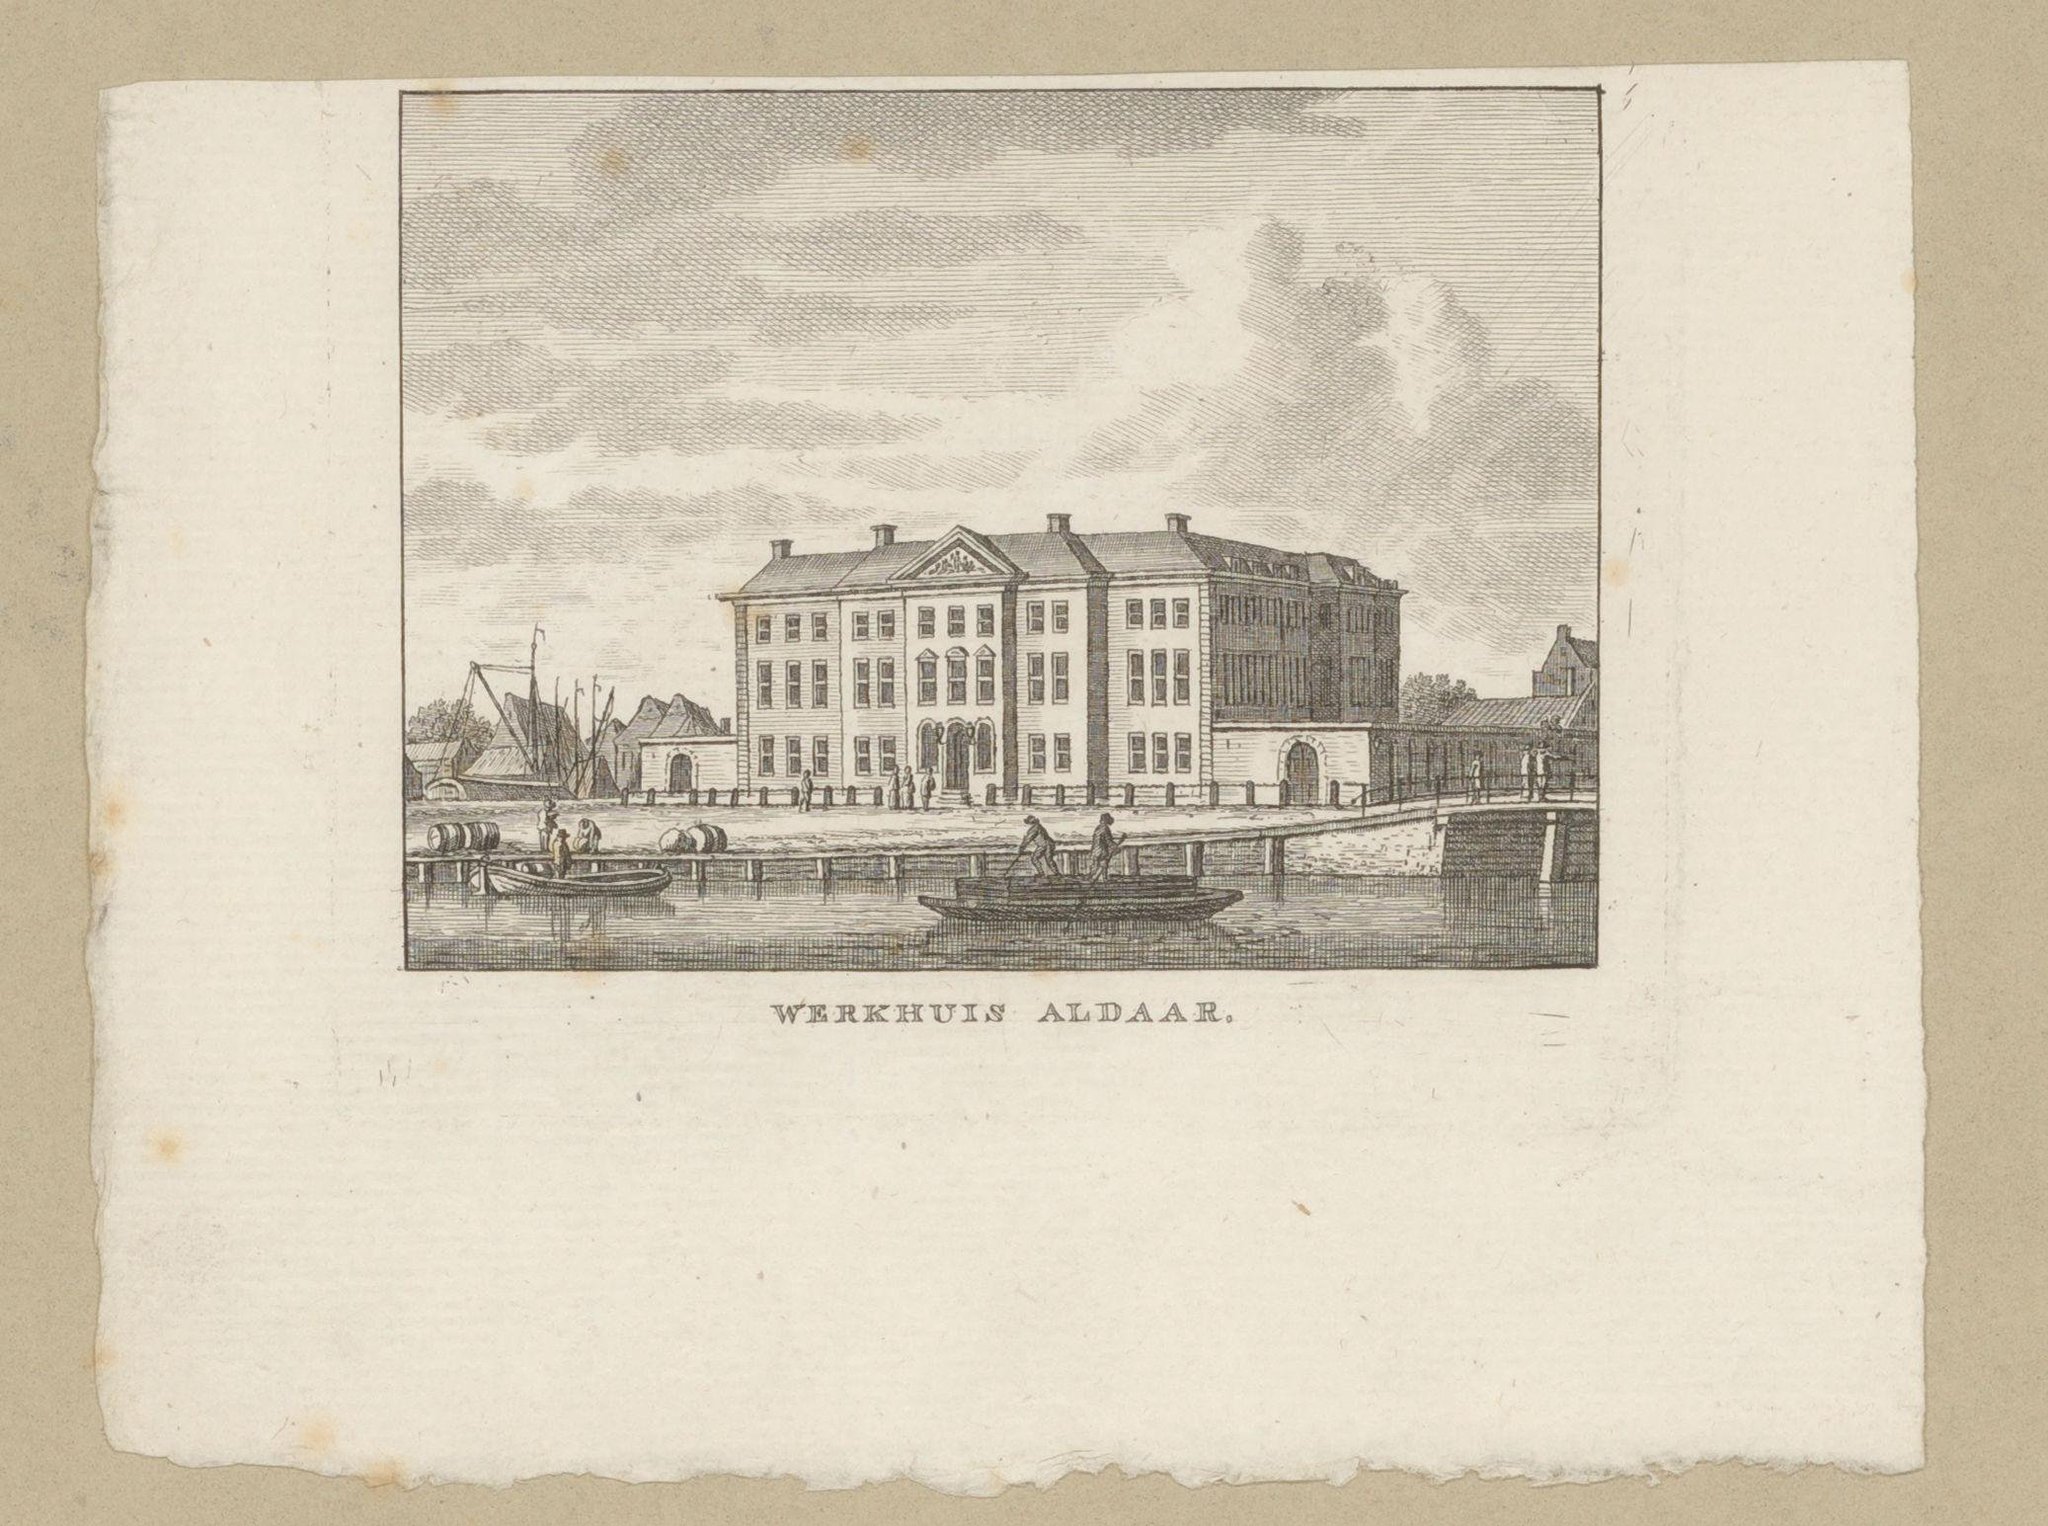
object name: print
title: Gezicht op het Nieuwe Werkhuis te Amsterdam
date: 1786-1792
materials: paper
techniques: etching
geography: northern netherlands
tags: prison, jail, canals, waters (in city), workhouse, penal camp, penitentiary, chain gang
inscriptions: collector's mark: Lugt 1641b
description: Prent mogelijk uit: Vaderlandsche gezichten, of afbeeldingen van den tegenwoordigen staat der Vereenigde Nederlanden (…). Amsterdam: Hendrik Gartman, Willem Vermandel en Jan Willem Smit, [1786-1792]. Deze publicatie is uitgegeven in afleveringen met ieder een eigen bifolium en inhoudsopgave. Alle prenten uit deze publicatie zijn gegraveerd door Carel Frederik Bendorp (I) en, in de meeste gevallen, gebaseerd op tekeningen van Jan Bulthuis.